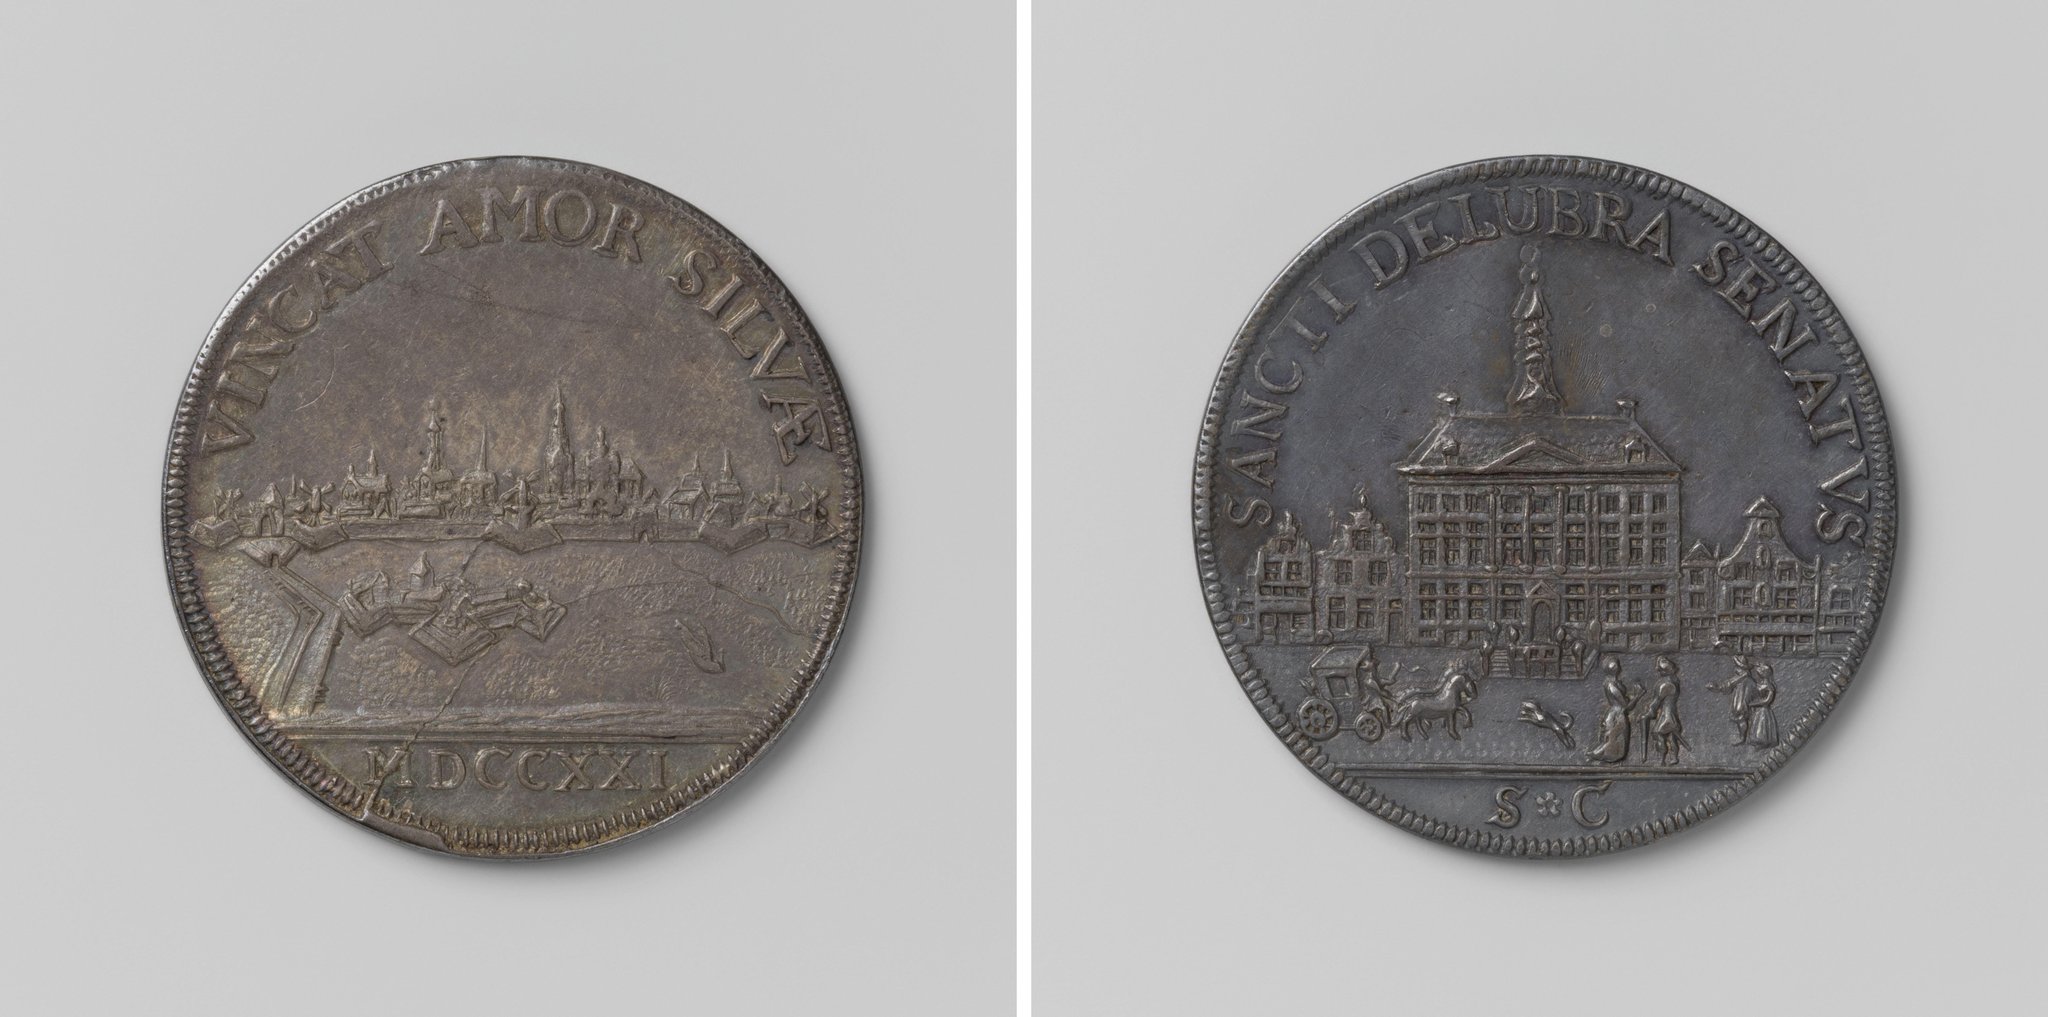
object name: council medal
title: Vroedschapspenning van de stad 's-Hertogenbosch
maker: theodorus casparus van berckel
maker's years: 1680-1734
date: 1721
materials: silver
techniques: striking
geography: den bosch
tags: den bosch